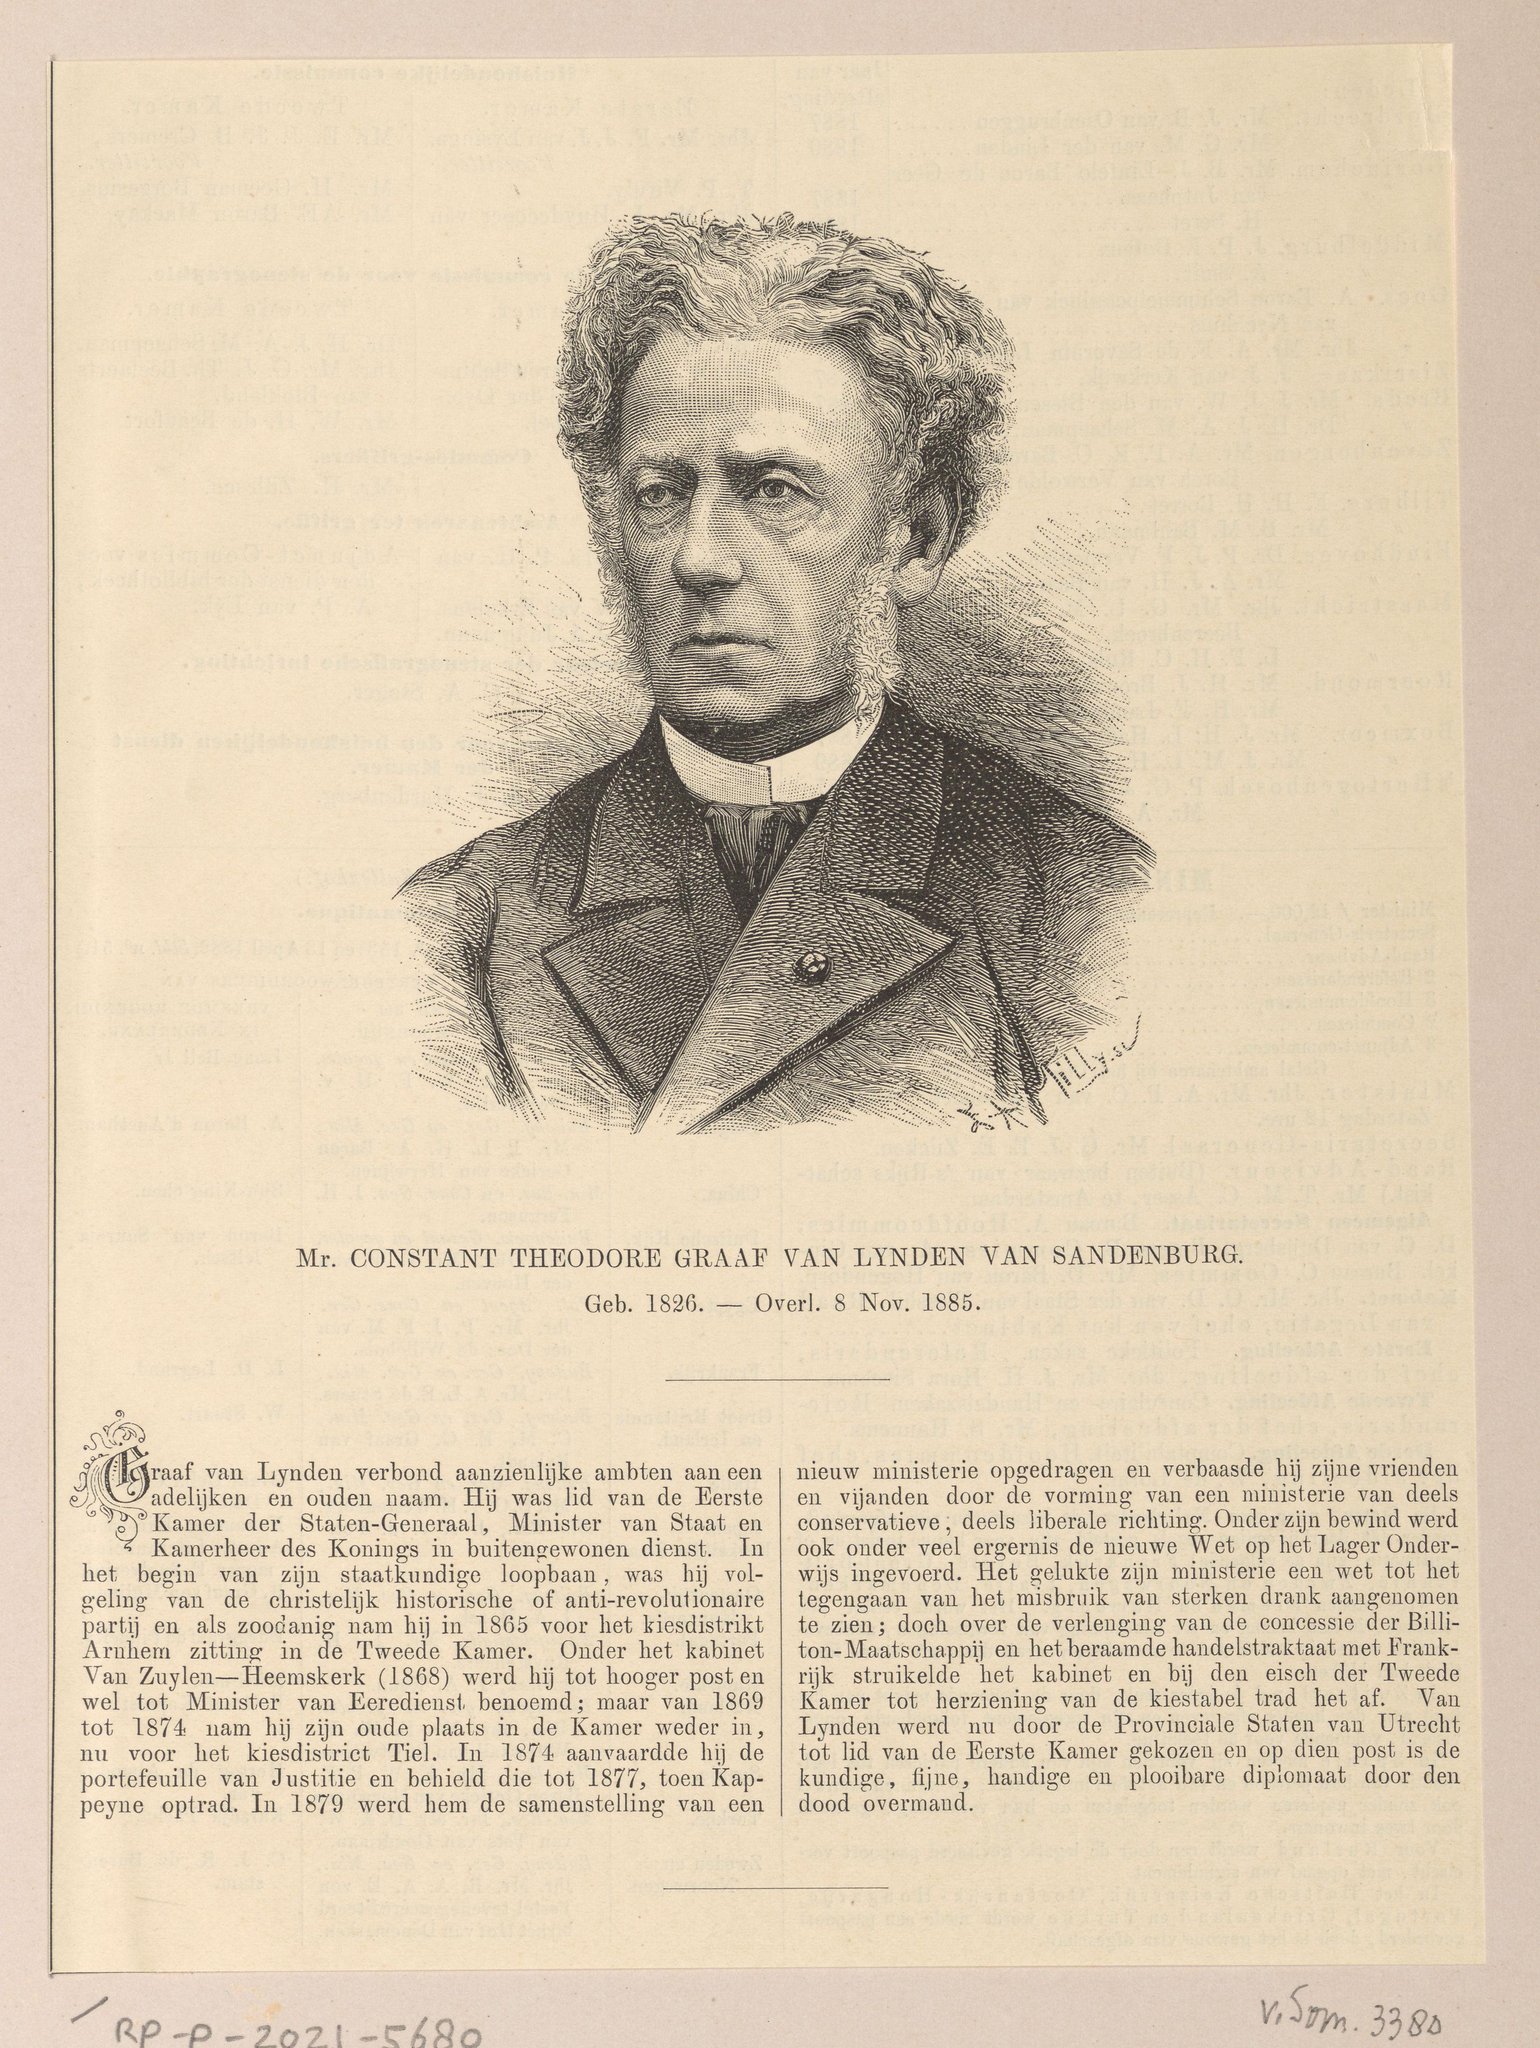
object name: print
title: Portret van Constantijn Theodore Lynden van Sandenburg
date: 1885-1887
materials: paper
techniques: letterpress printing, engraving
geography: amsterdam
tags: historical persons, politician, e.g. party leader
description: De prent is, met andere tekst in boekdruk, gebruikt in: Eigen Haard (1885), nr. 49.